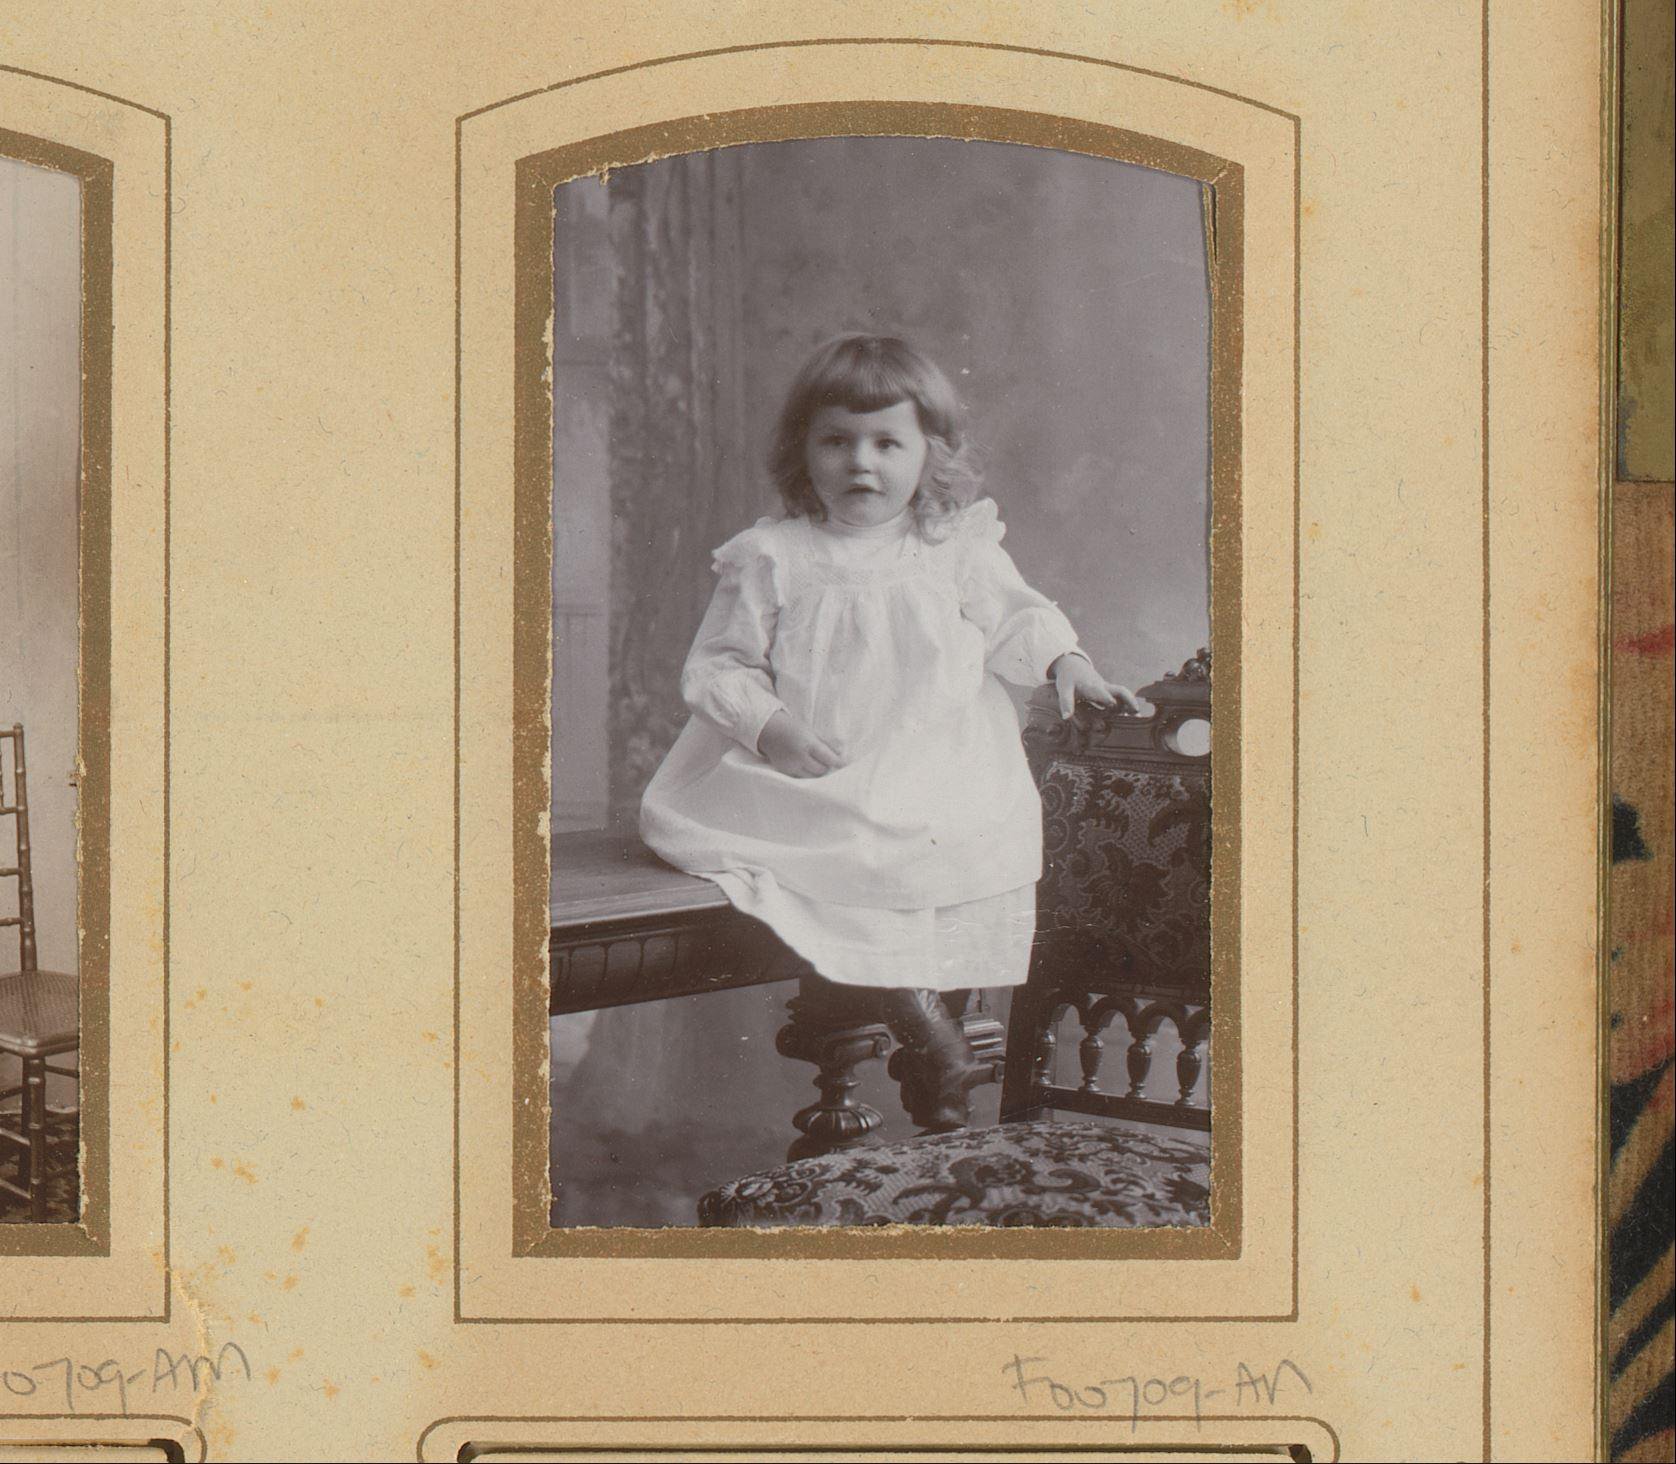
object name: album leaf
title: Portret van een zittend meisje in witte jurk op tafel bij een stoel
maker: cornelis johannes lodewicus vermeulen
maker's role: fotograaf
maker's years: 1861-1936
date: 1902-1904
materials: cardboard, photographic support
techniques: collodion silver print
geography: netherlands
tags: girl (child between toddler and youth)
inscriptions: inscription: ‘C.J.L. Vermeulen/ Den Haag/ Toussaintkade 11/ Amsterdam/ Heiligenweg hoek Singel’, annotation: ‘[...] geb. 19 Aug 1899/ gefot. April 1902’